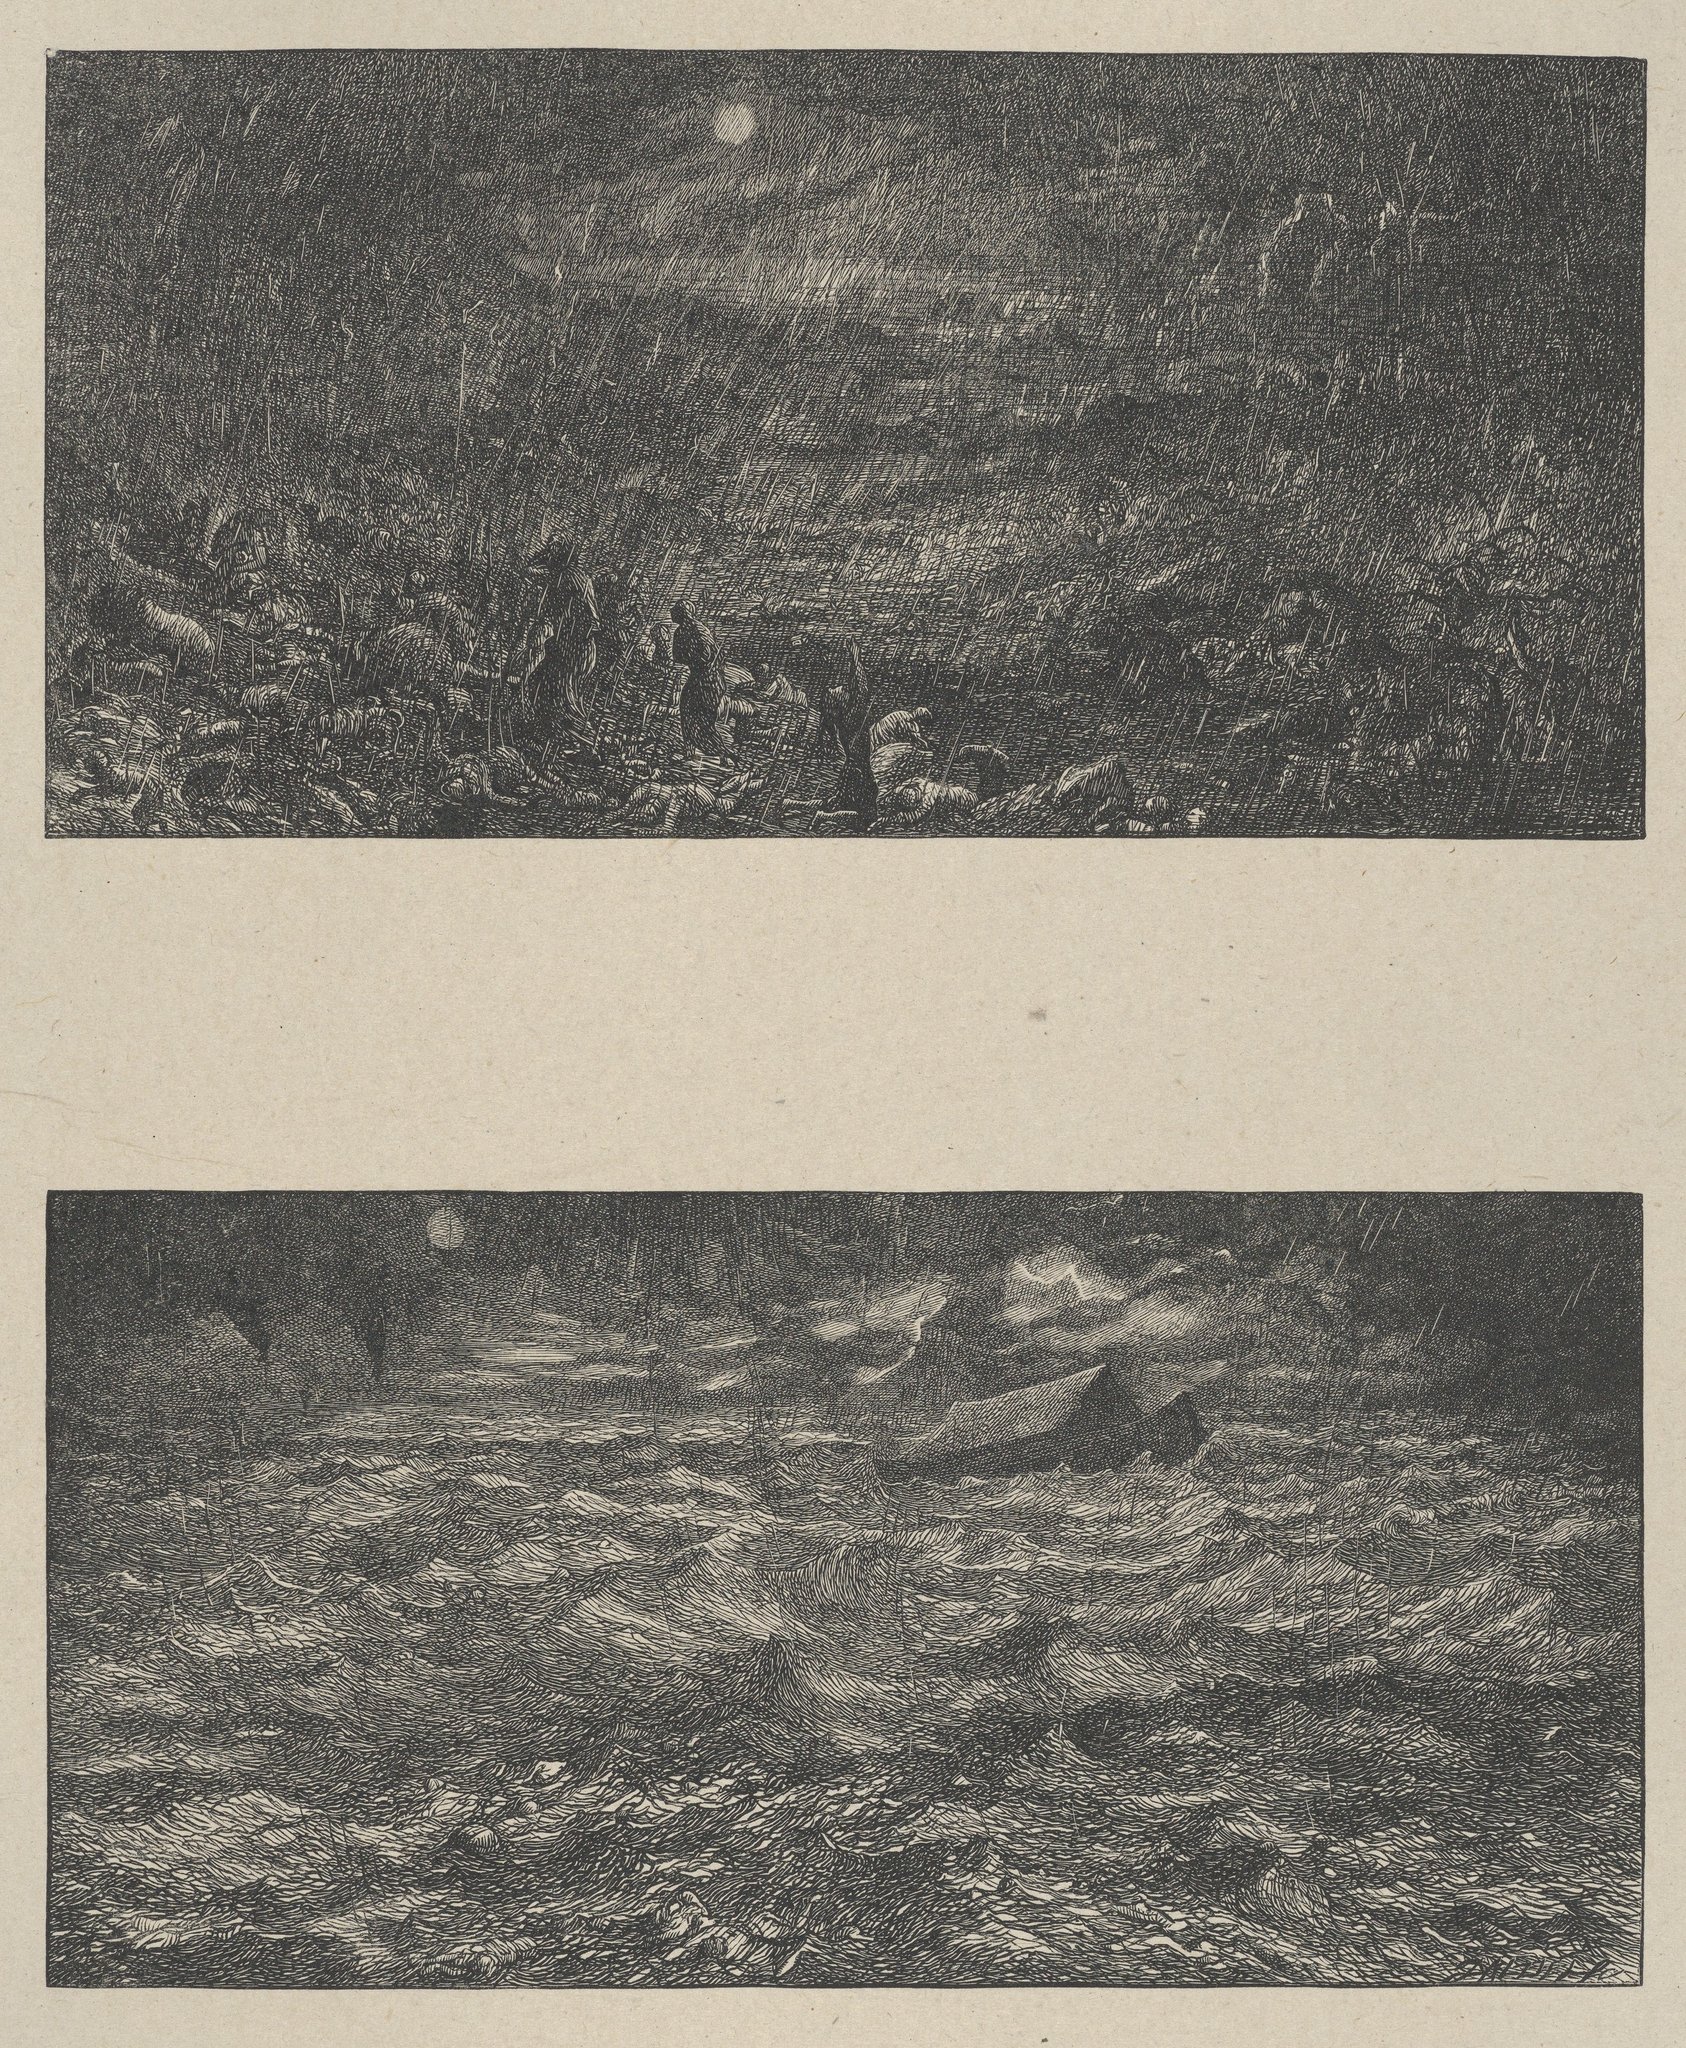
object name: print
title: The Deluge–The Ark on the Waters, from "Dalziels' Bible Gallery"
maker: thomas dalziel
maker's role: artist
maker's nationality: british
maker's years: 1823-1906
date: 1865-1881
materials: paper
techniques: engraving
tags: floods,rain,ships